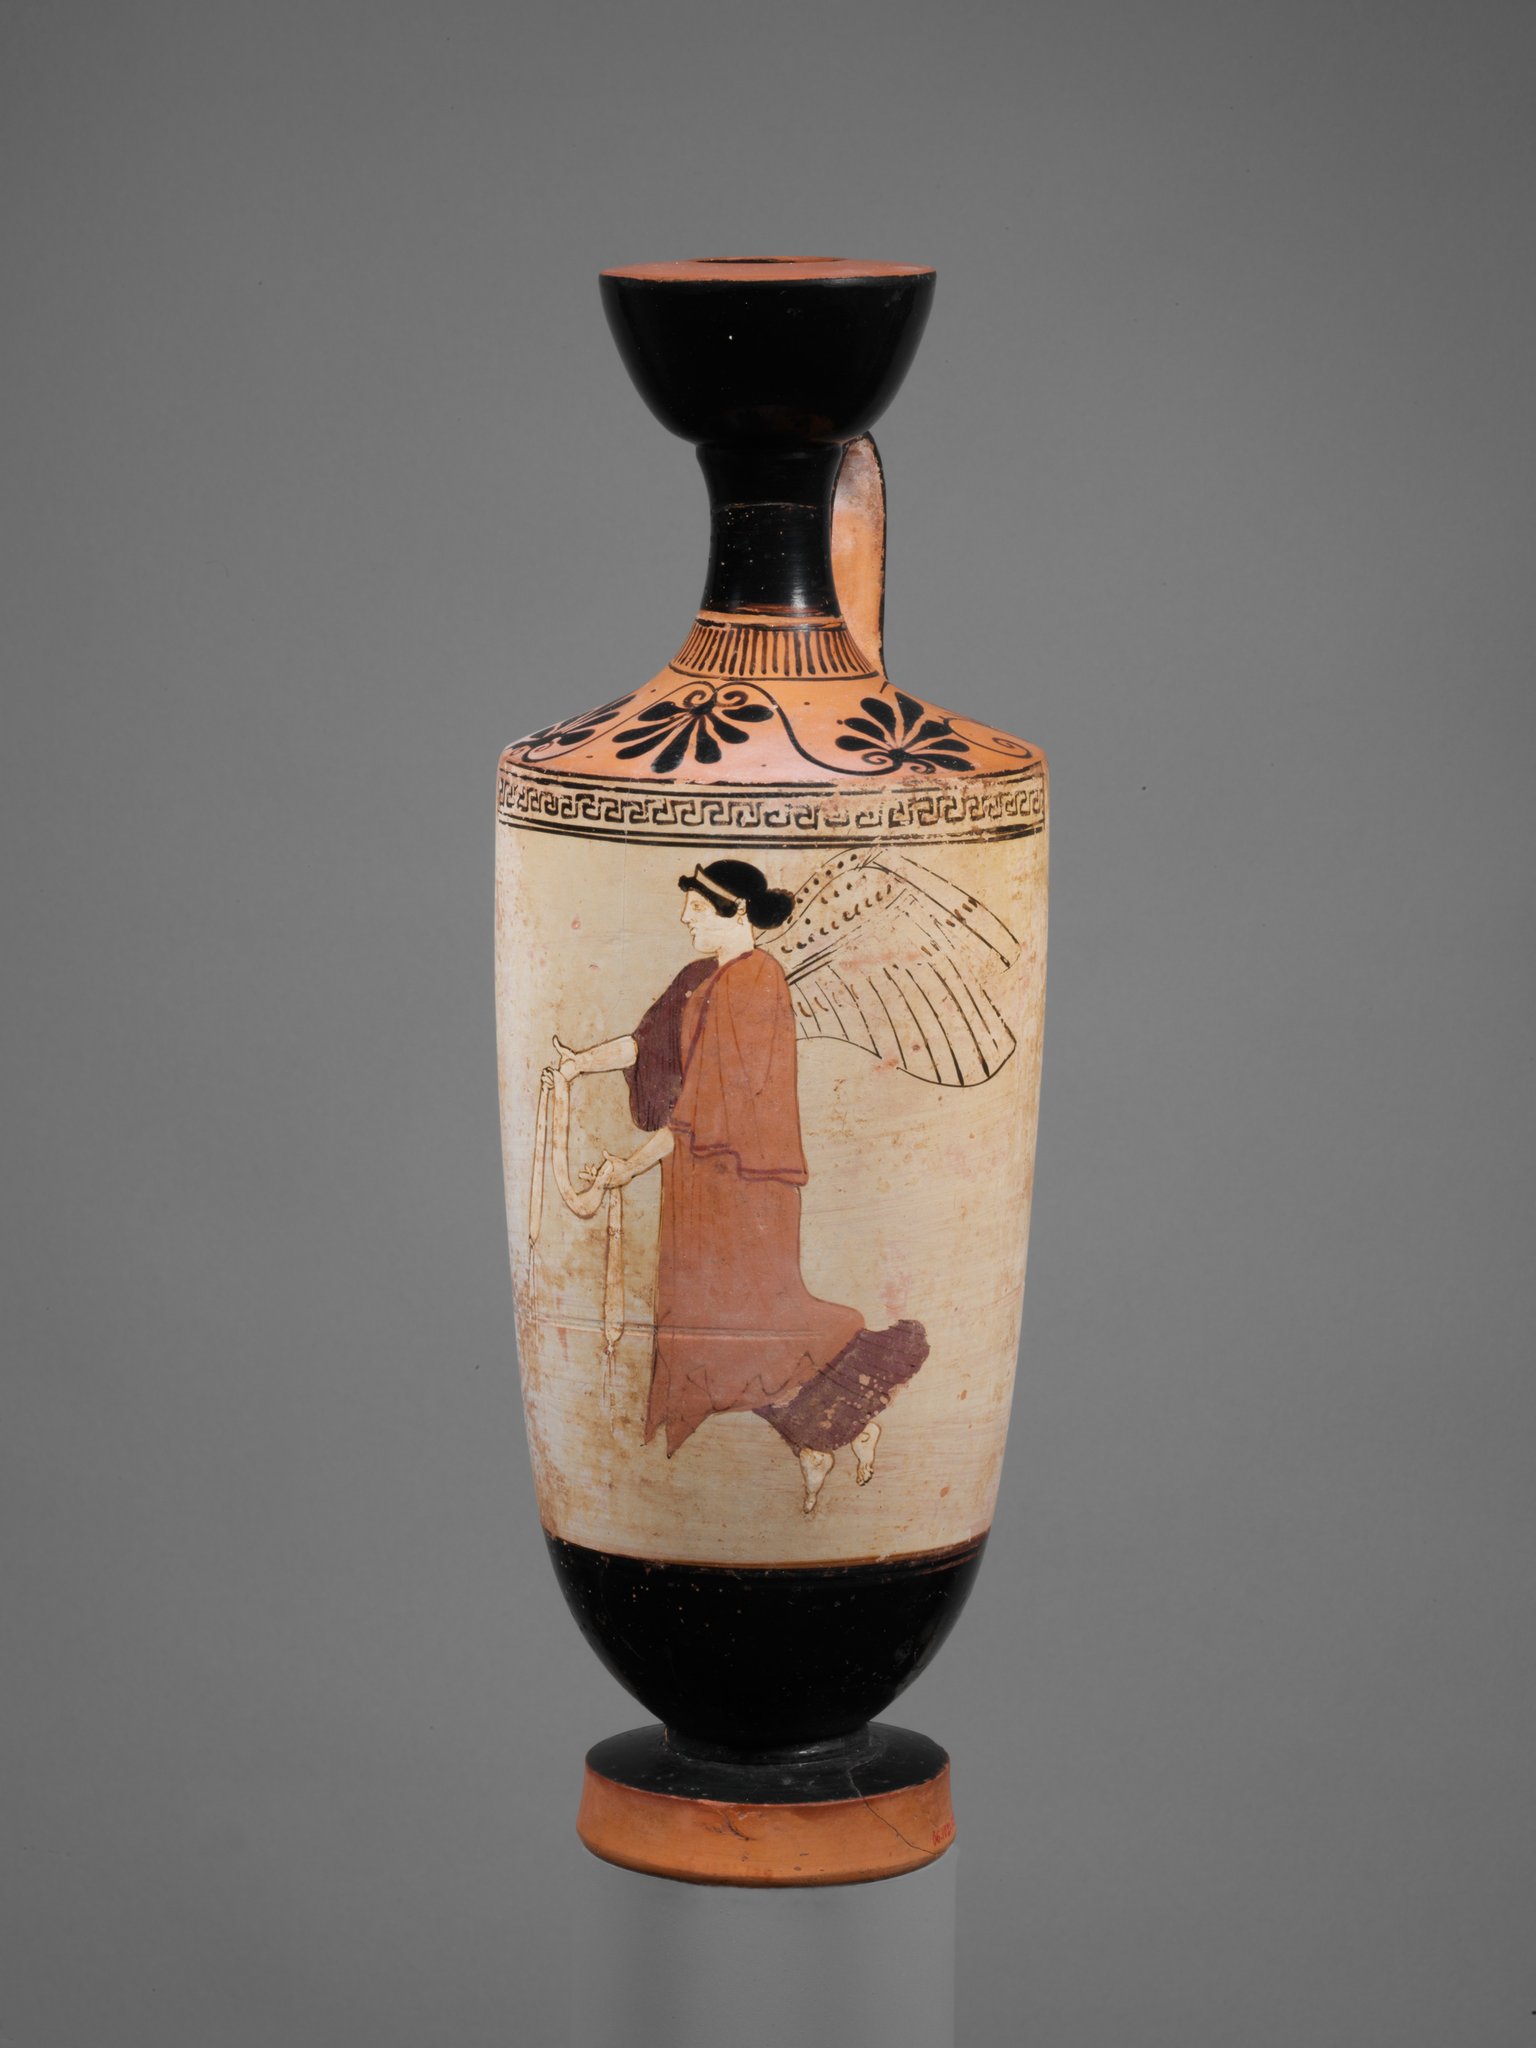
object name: lekythos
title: Terracotta lekythos (oil flask)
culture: greek, attic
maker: carlsruhe painter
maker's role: artist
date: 460-450 BCE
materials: terracotta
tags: nike